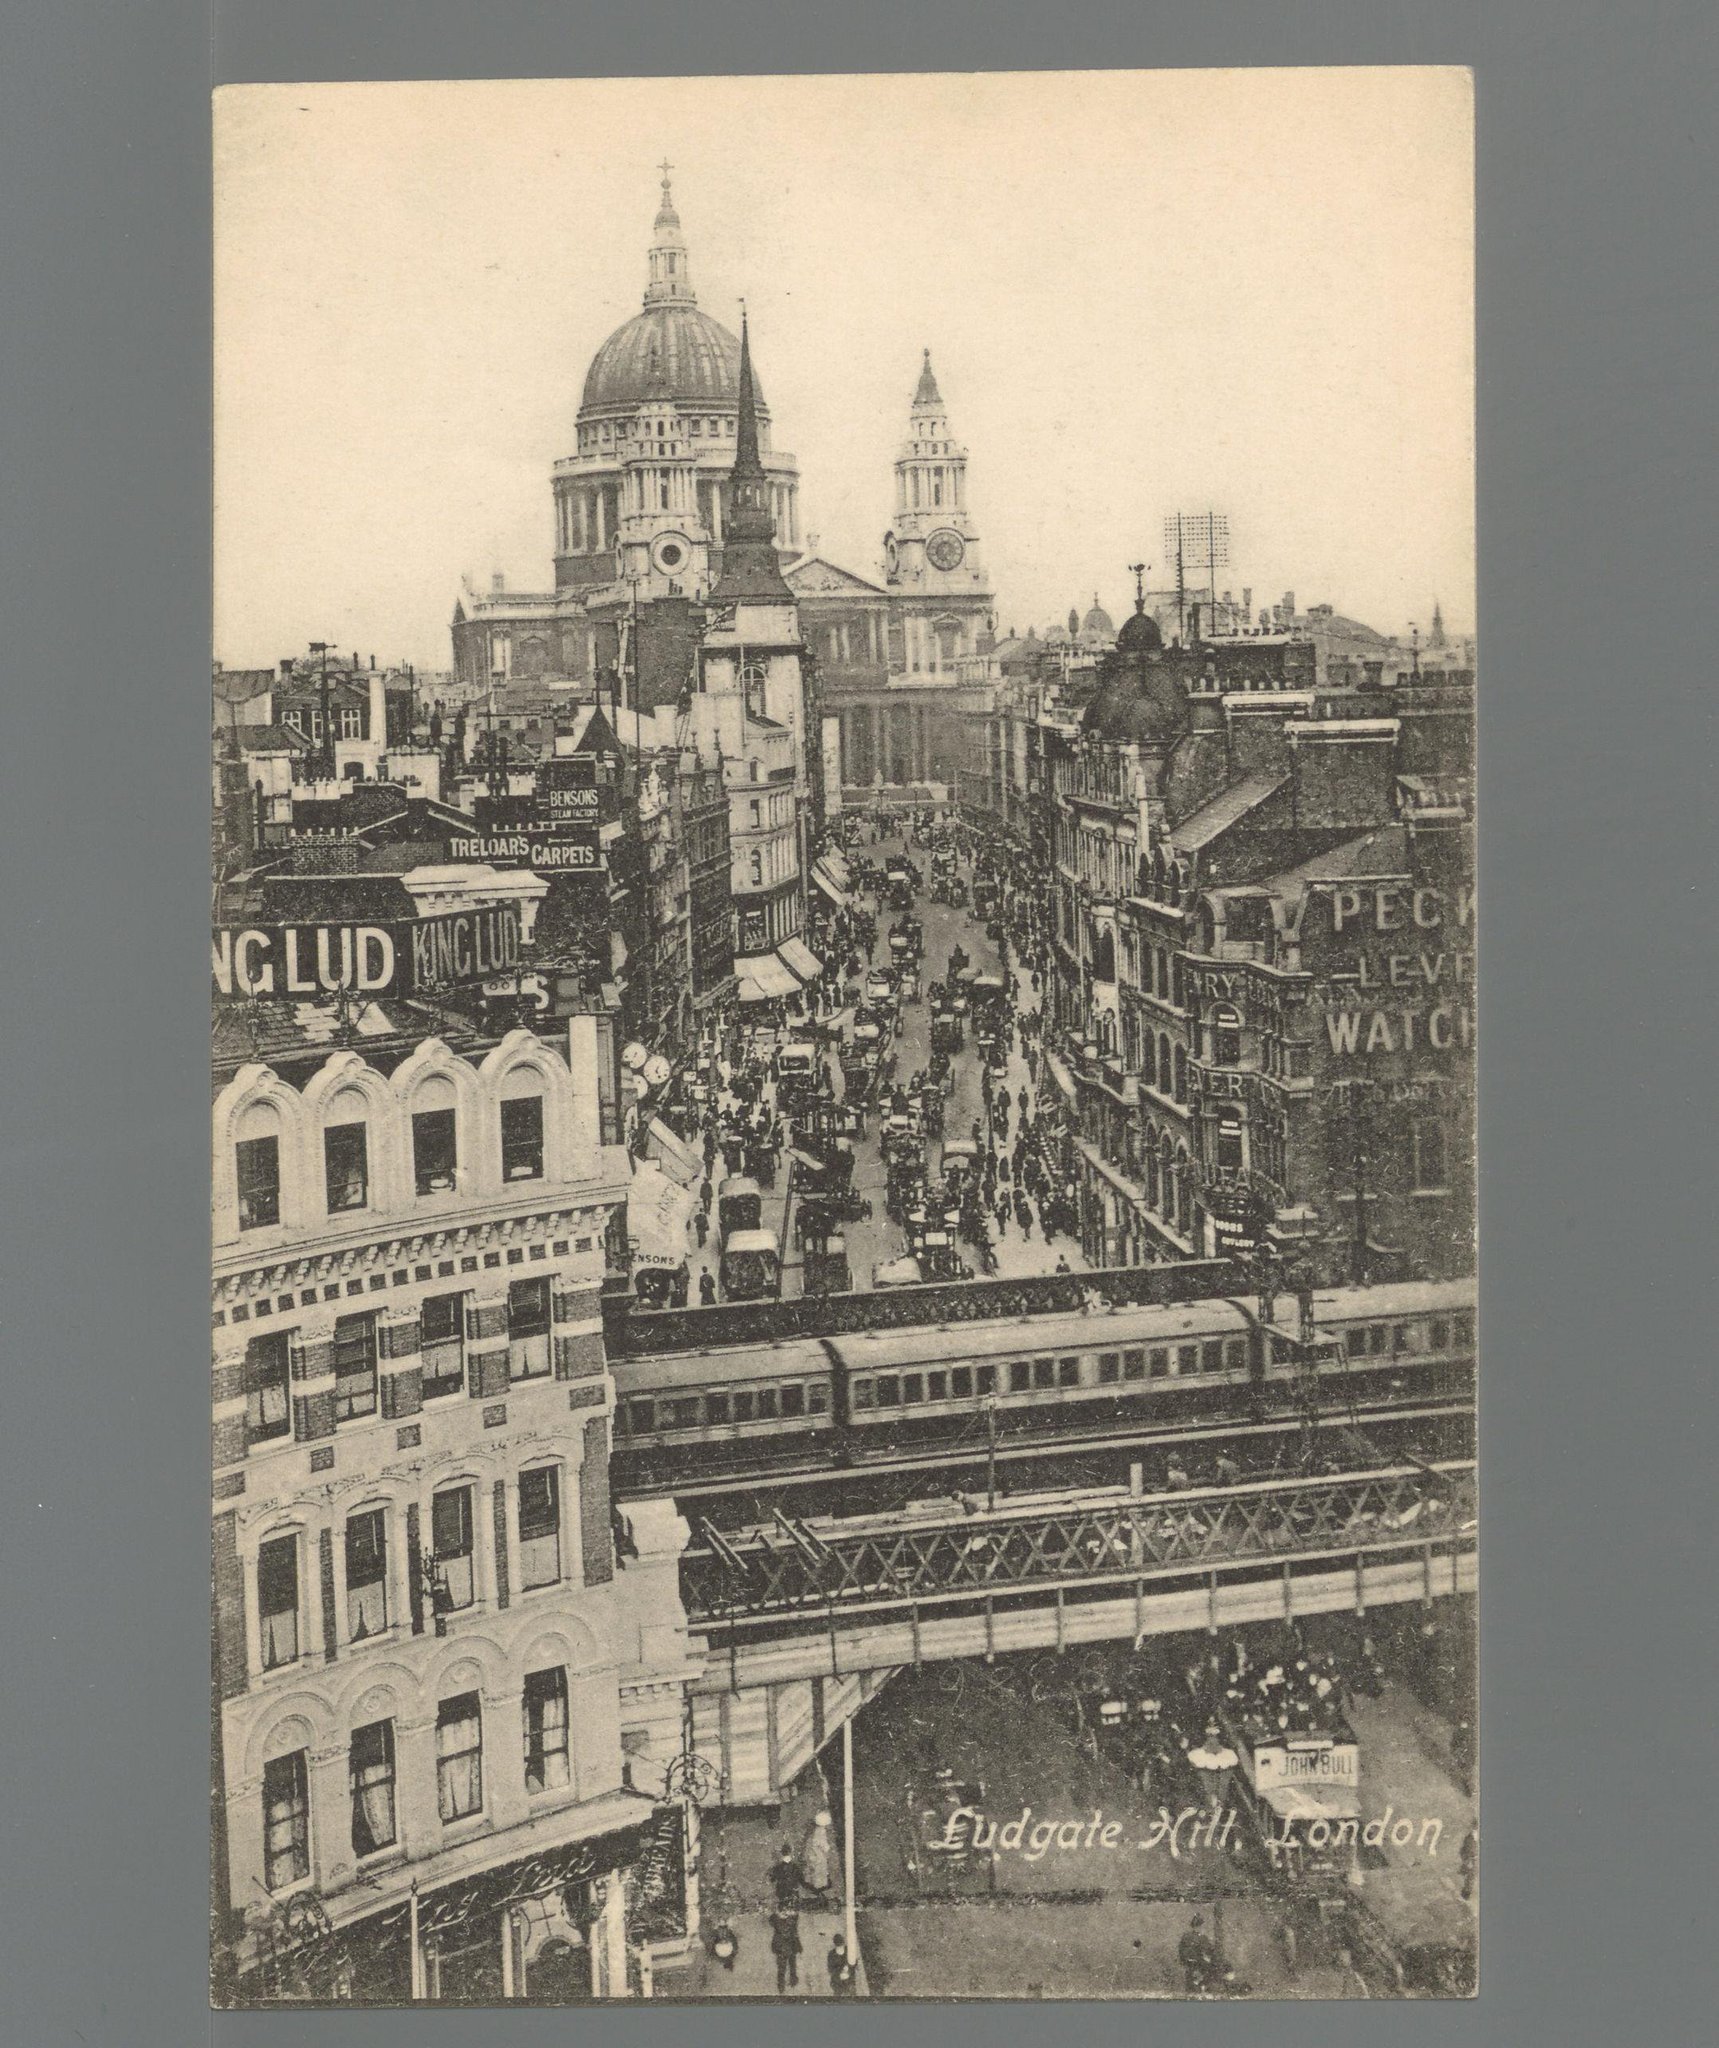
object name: photomechanical print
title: Valentine's Series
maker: Anonymous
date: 1902-1930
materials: cardboard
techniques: photograph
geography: dundee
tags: underground railway, 'métro', church (exterior), street